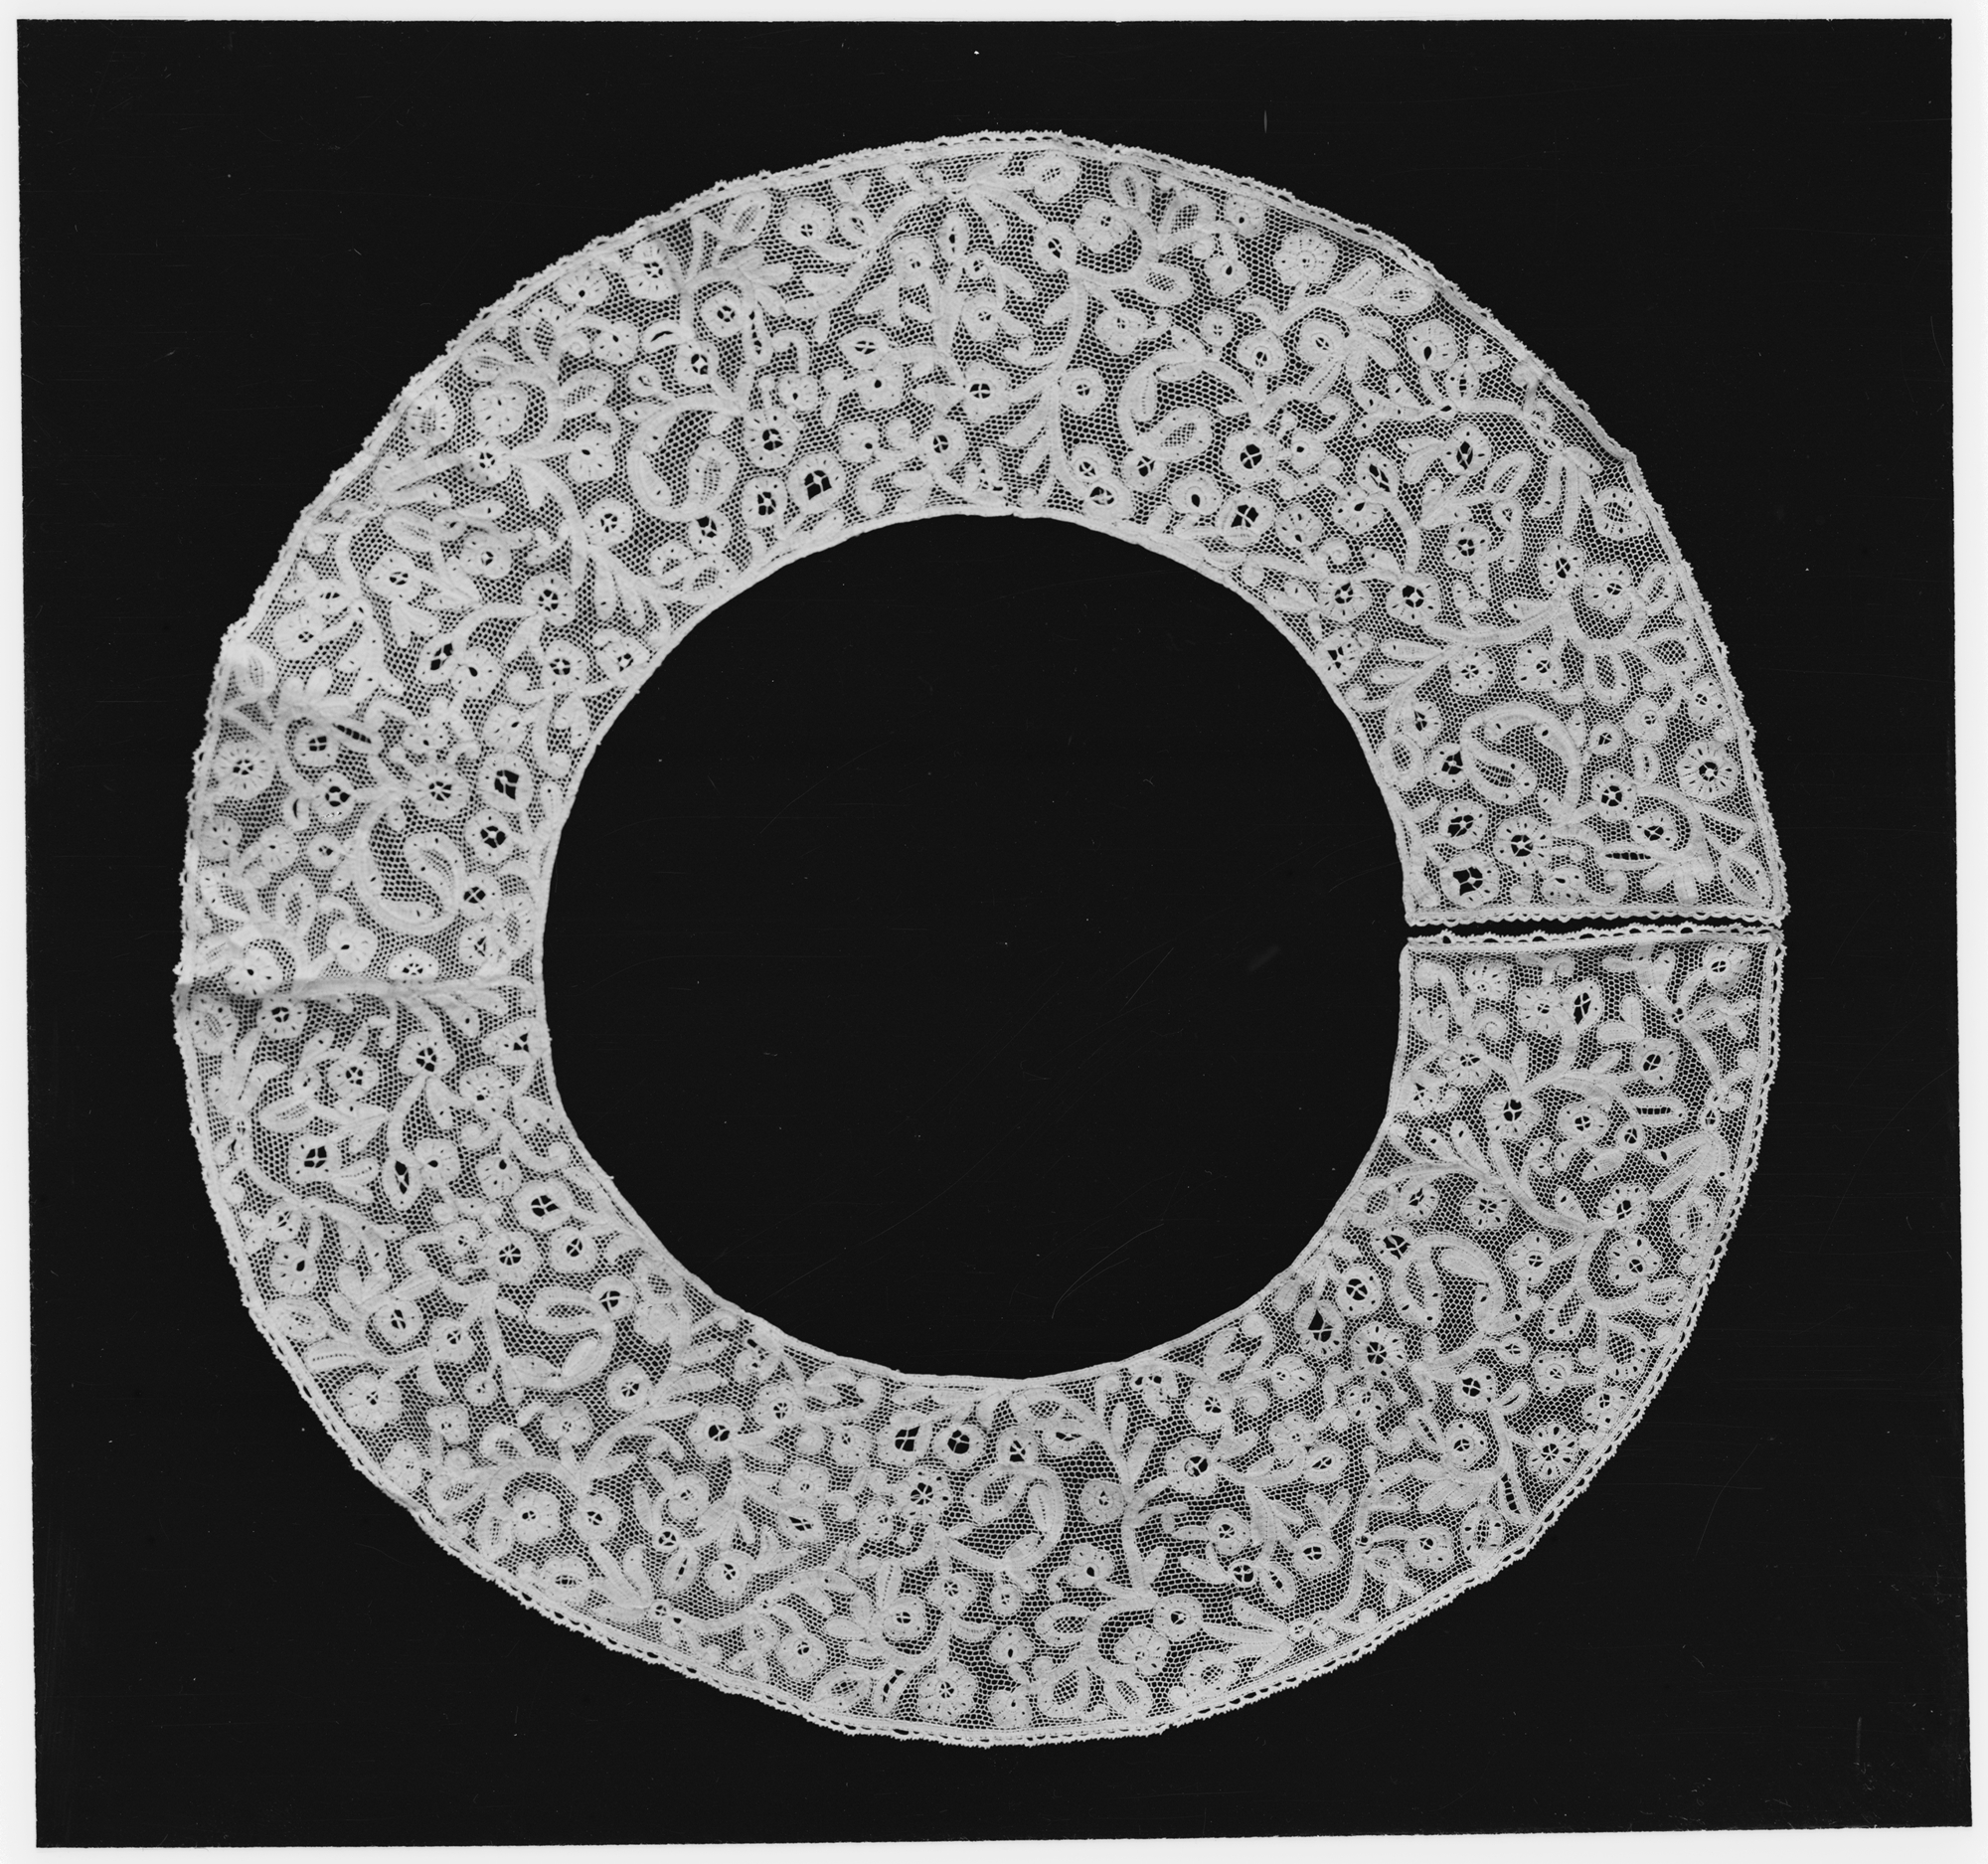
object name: bertha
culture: belgian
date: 1900